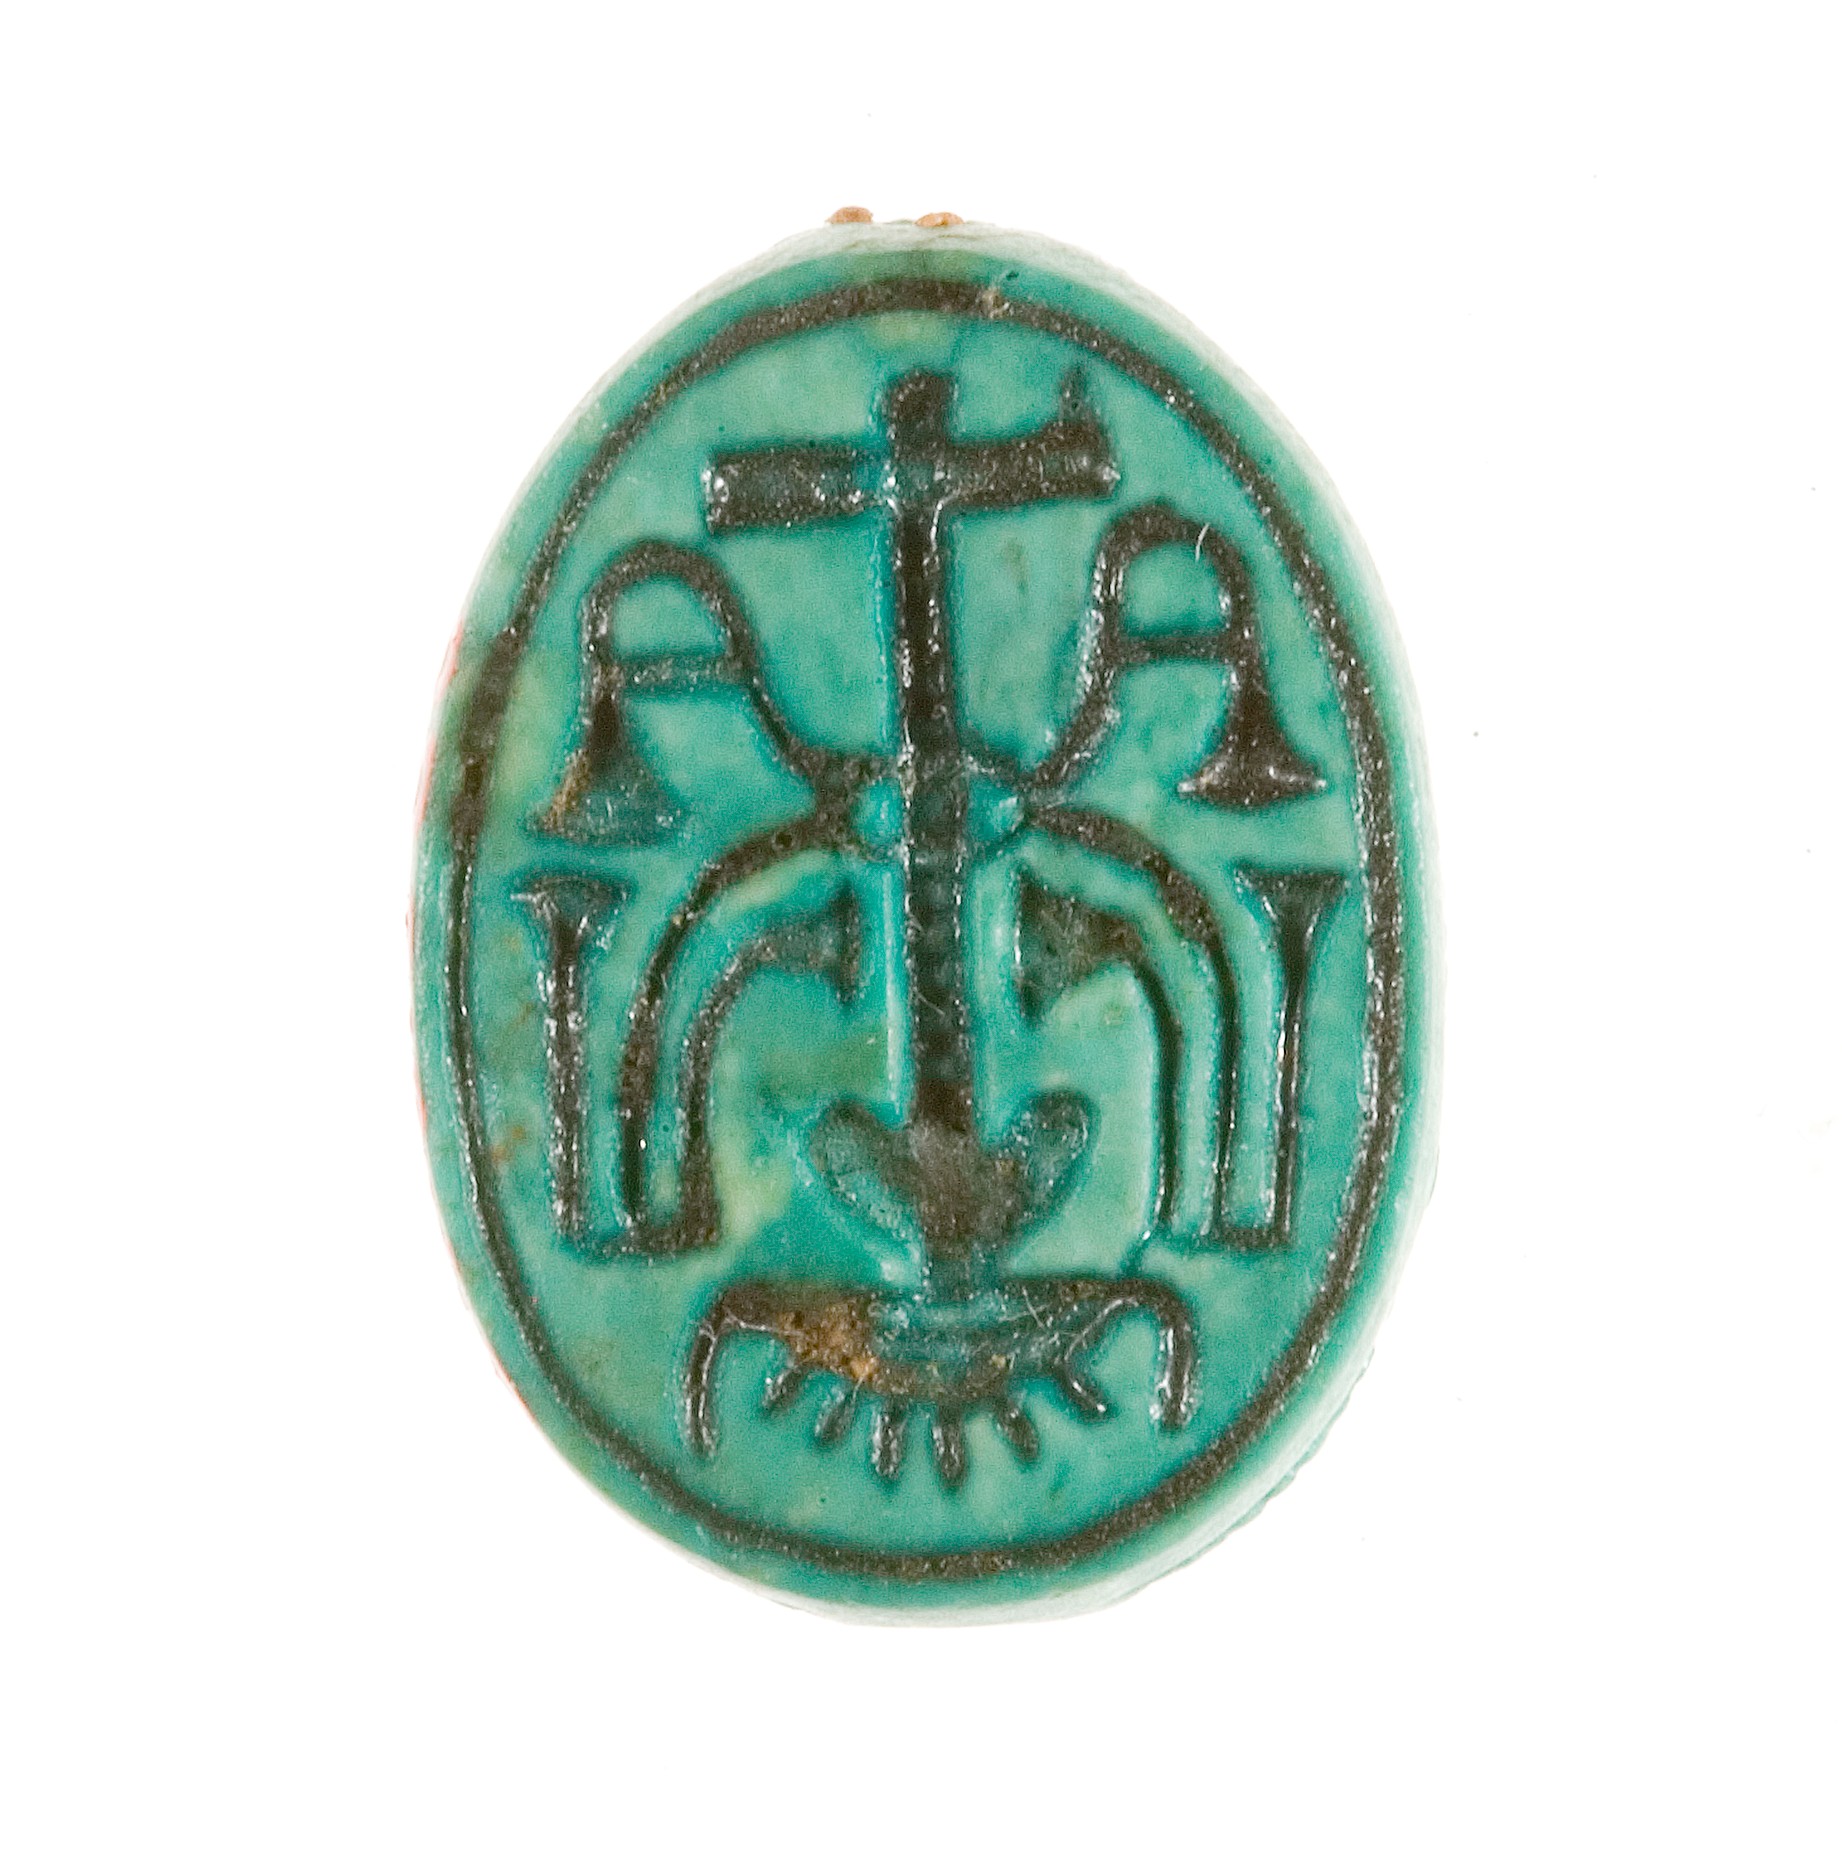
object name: scarab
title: Scarab Inscribed with a Hieroglyphic Motif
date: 1479-1458 BCE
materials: stone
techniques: glazing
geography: egypt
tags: scarabs